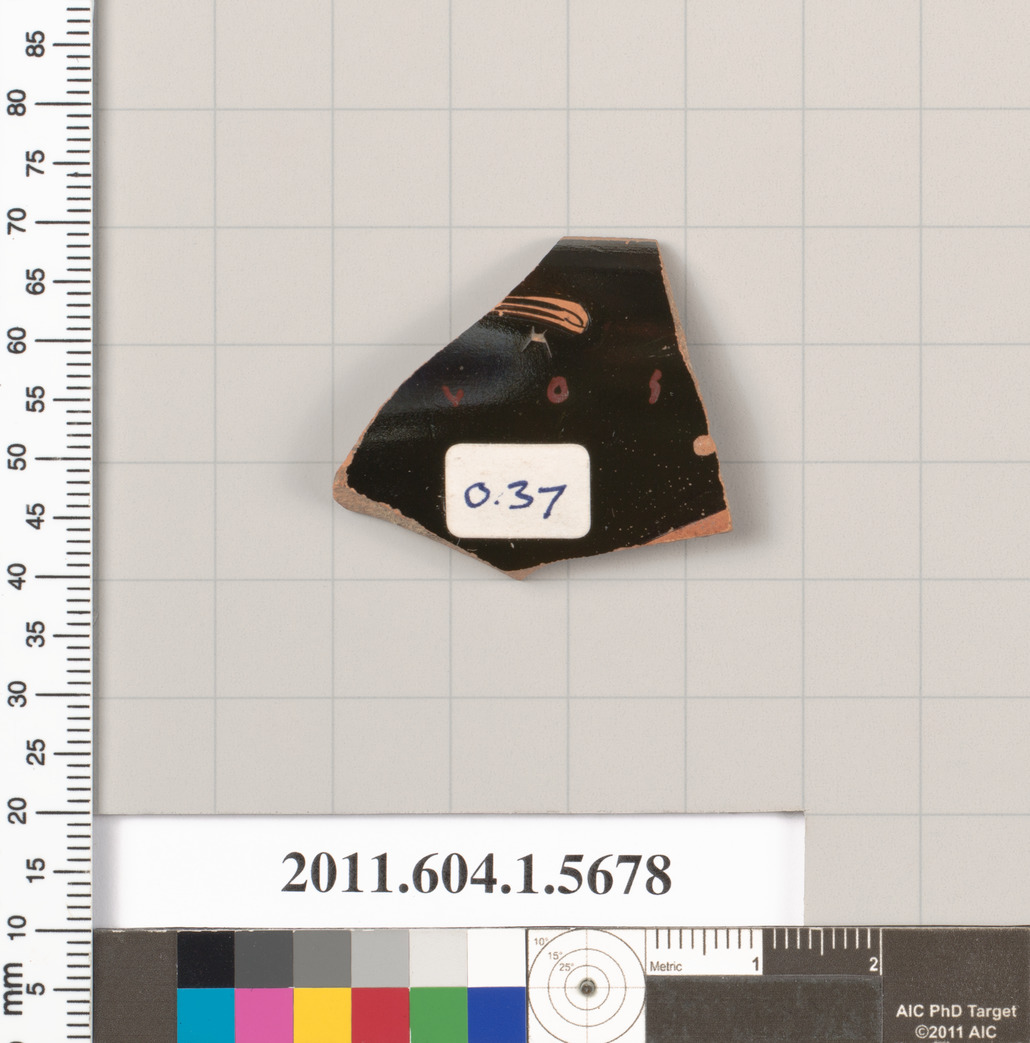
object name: kylix fragment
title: Terracotta rim fragment of a kylix (drinking cup)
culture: greek, attic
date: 500-490 BCE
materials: terracotta